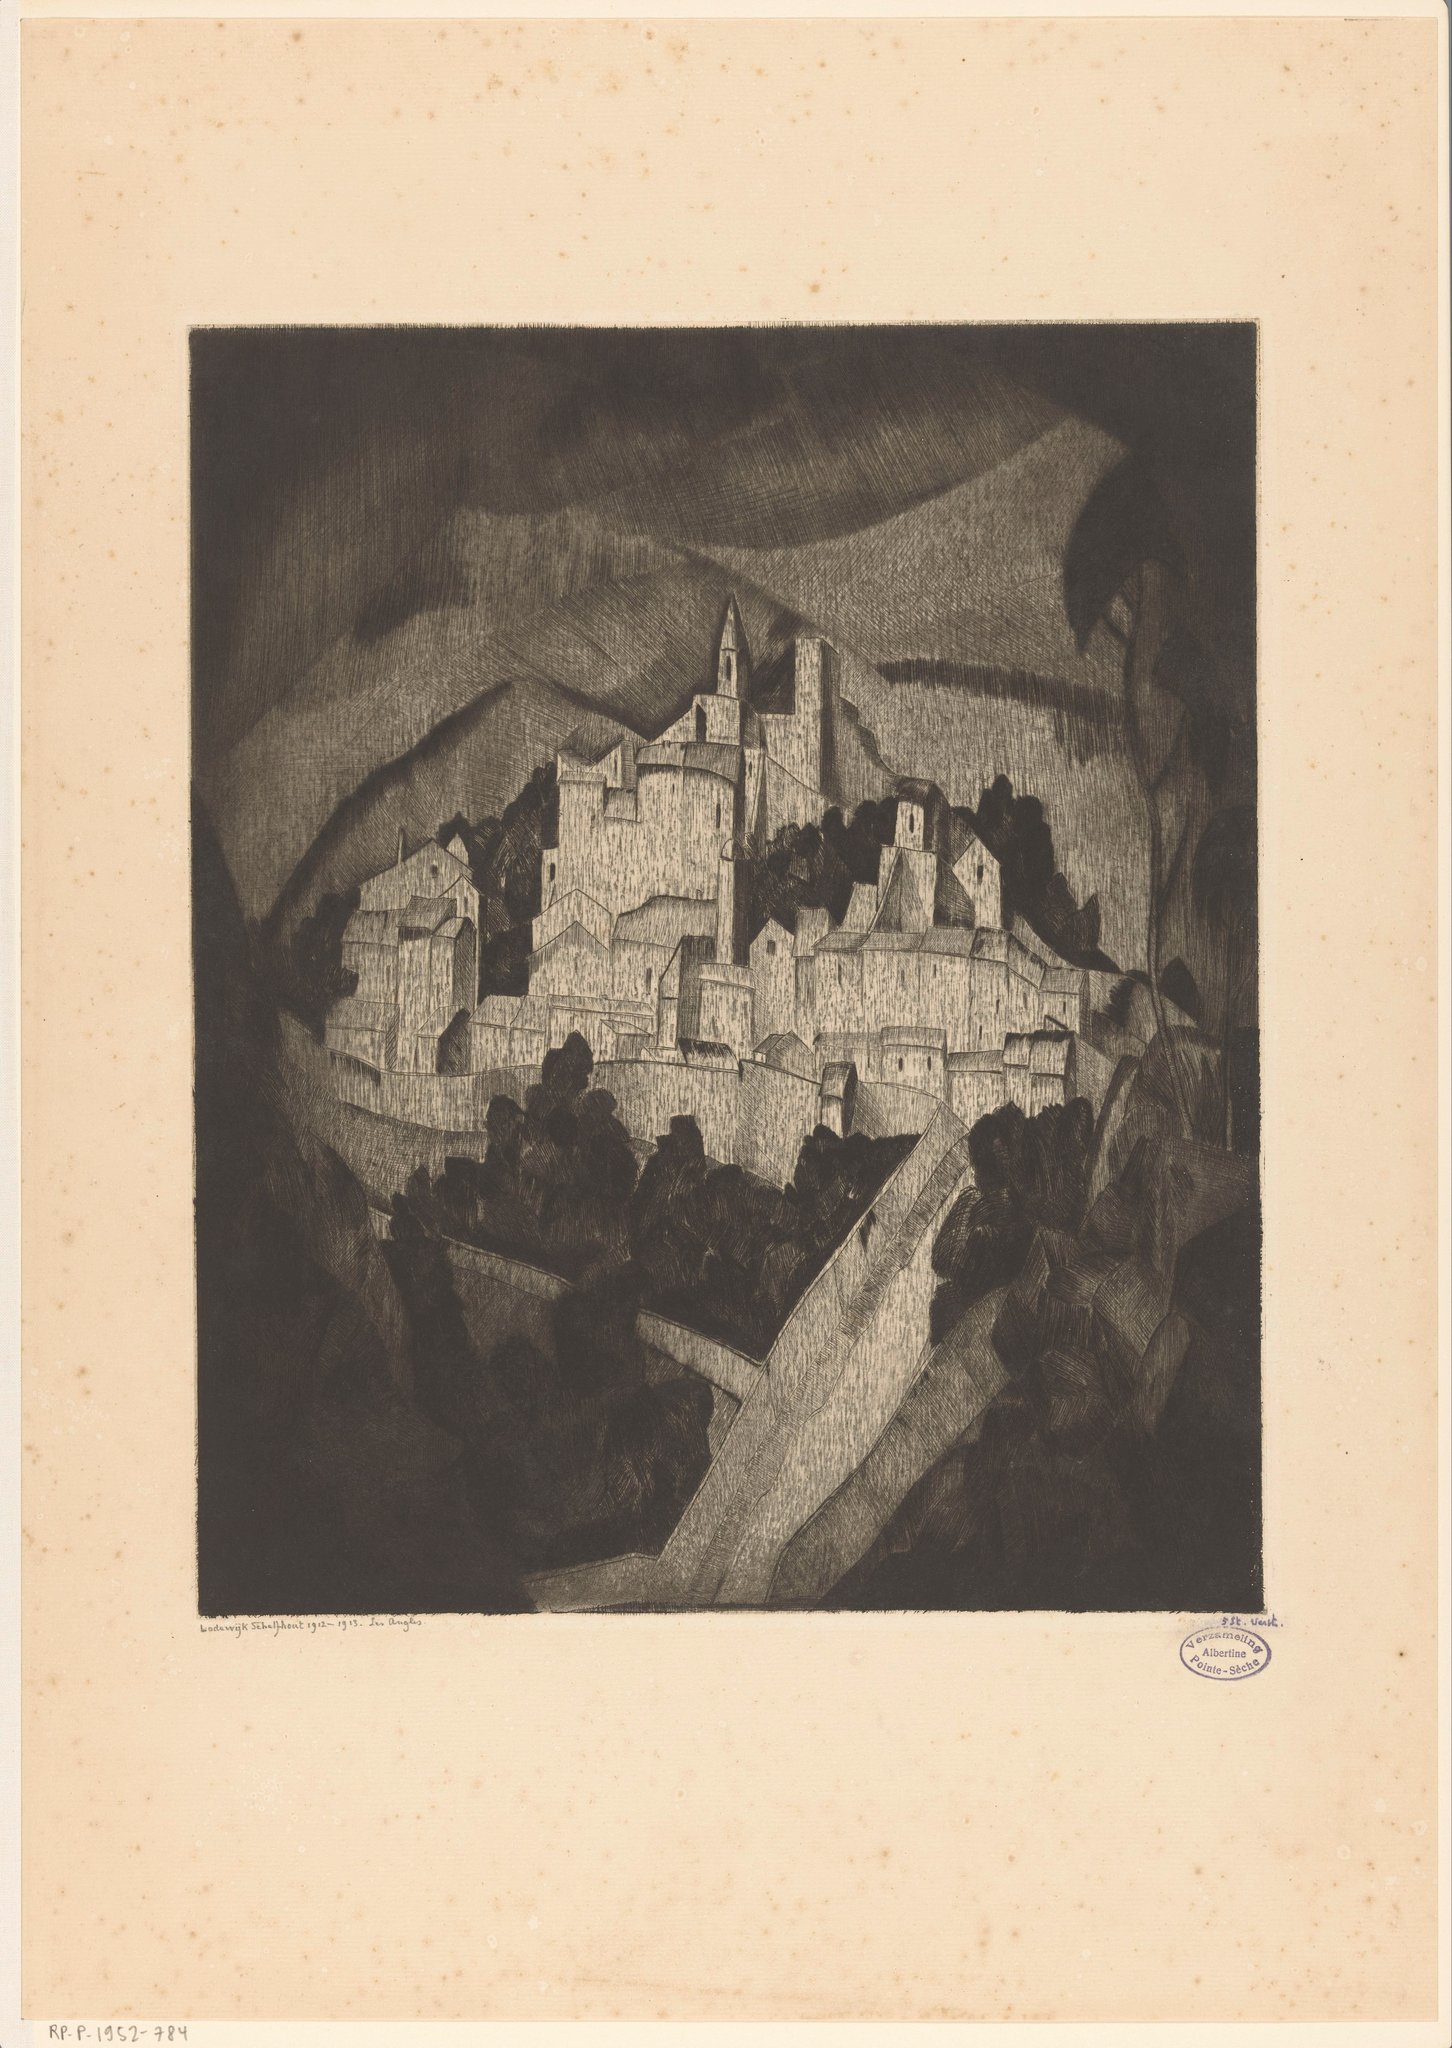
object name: print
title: Les Angles I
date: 1912-1913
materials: paper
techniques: drypoint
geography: netherlands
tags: low hill country, village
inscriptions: collector's mark: Lugt 2760, collector's mark: Lugt 5i, collector's mark: Lugt 2228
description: Het dorp Les Angles, gelegen op een heuvel nabij de stad Avignon in het zuiden van Frankrijk.